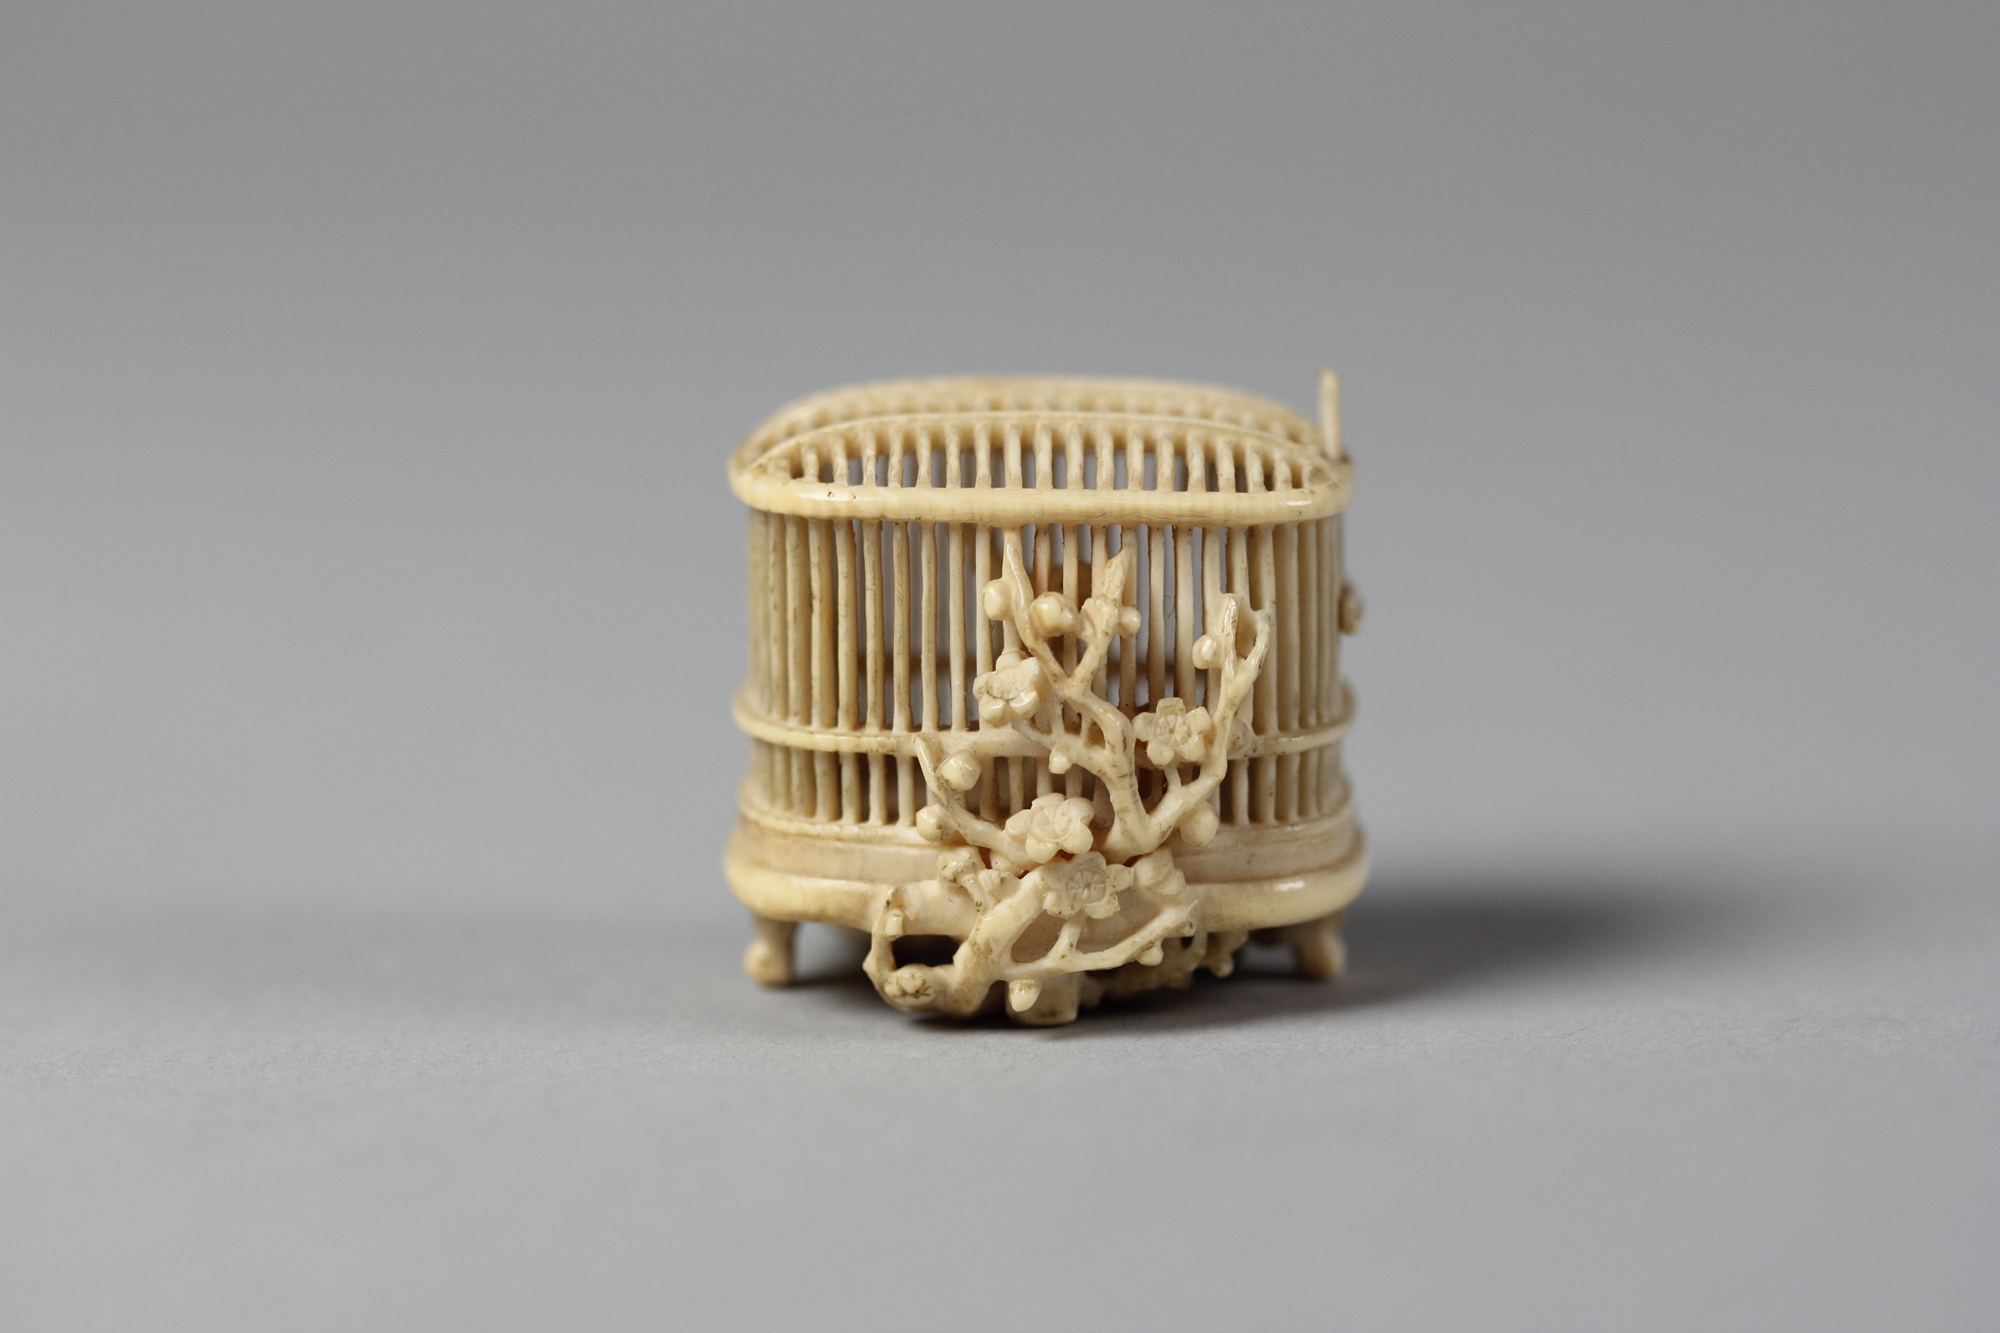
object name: netsuke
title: Netsuke of Bird Cage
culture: japanese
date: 1801-1900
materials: ivory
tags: flowers